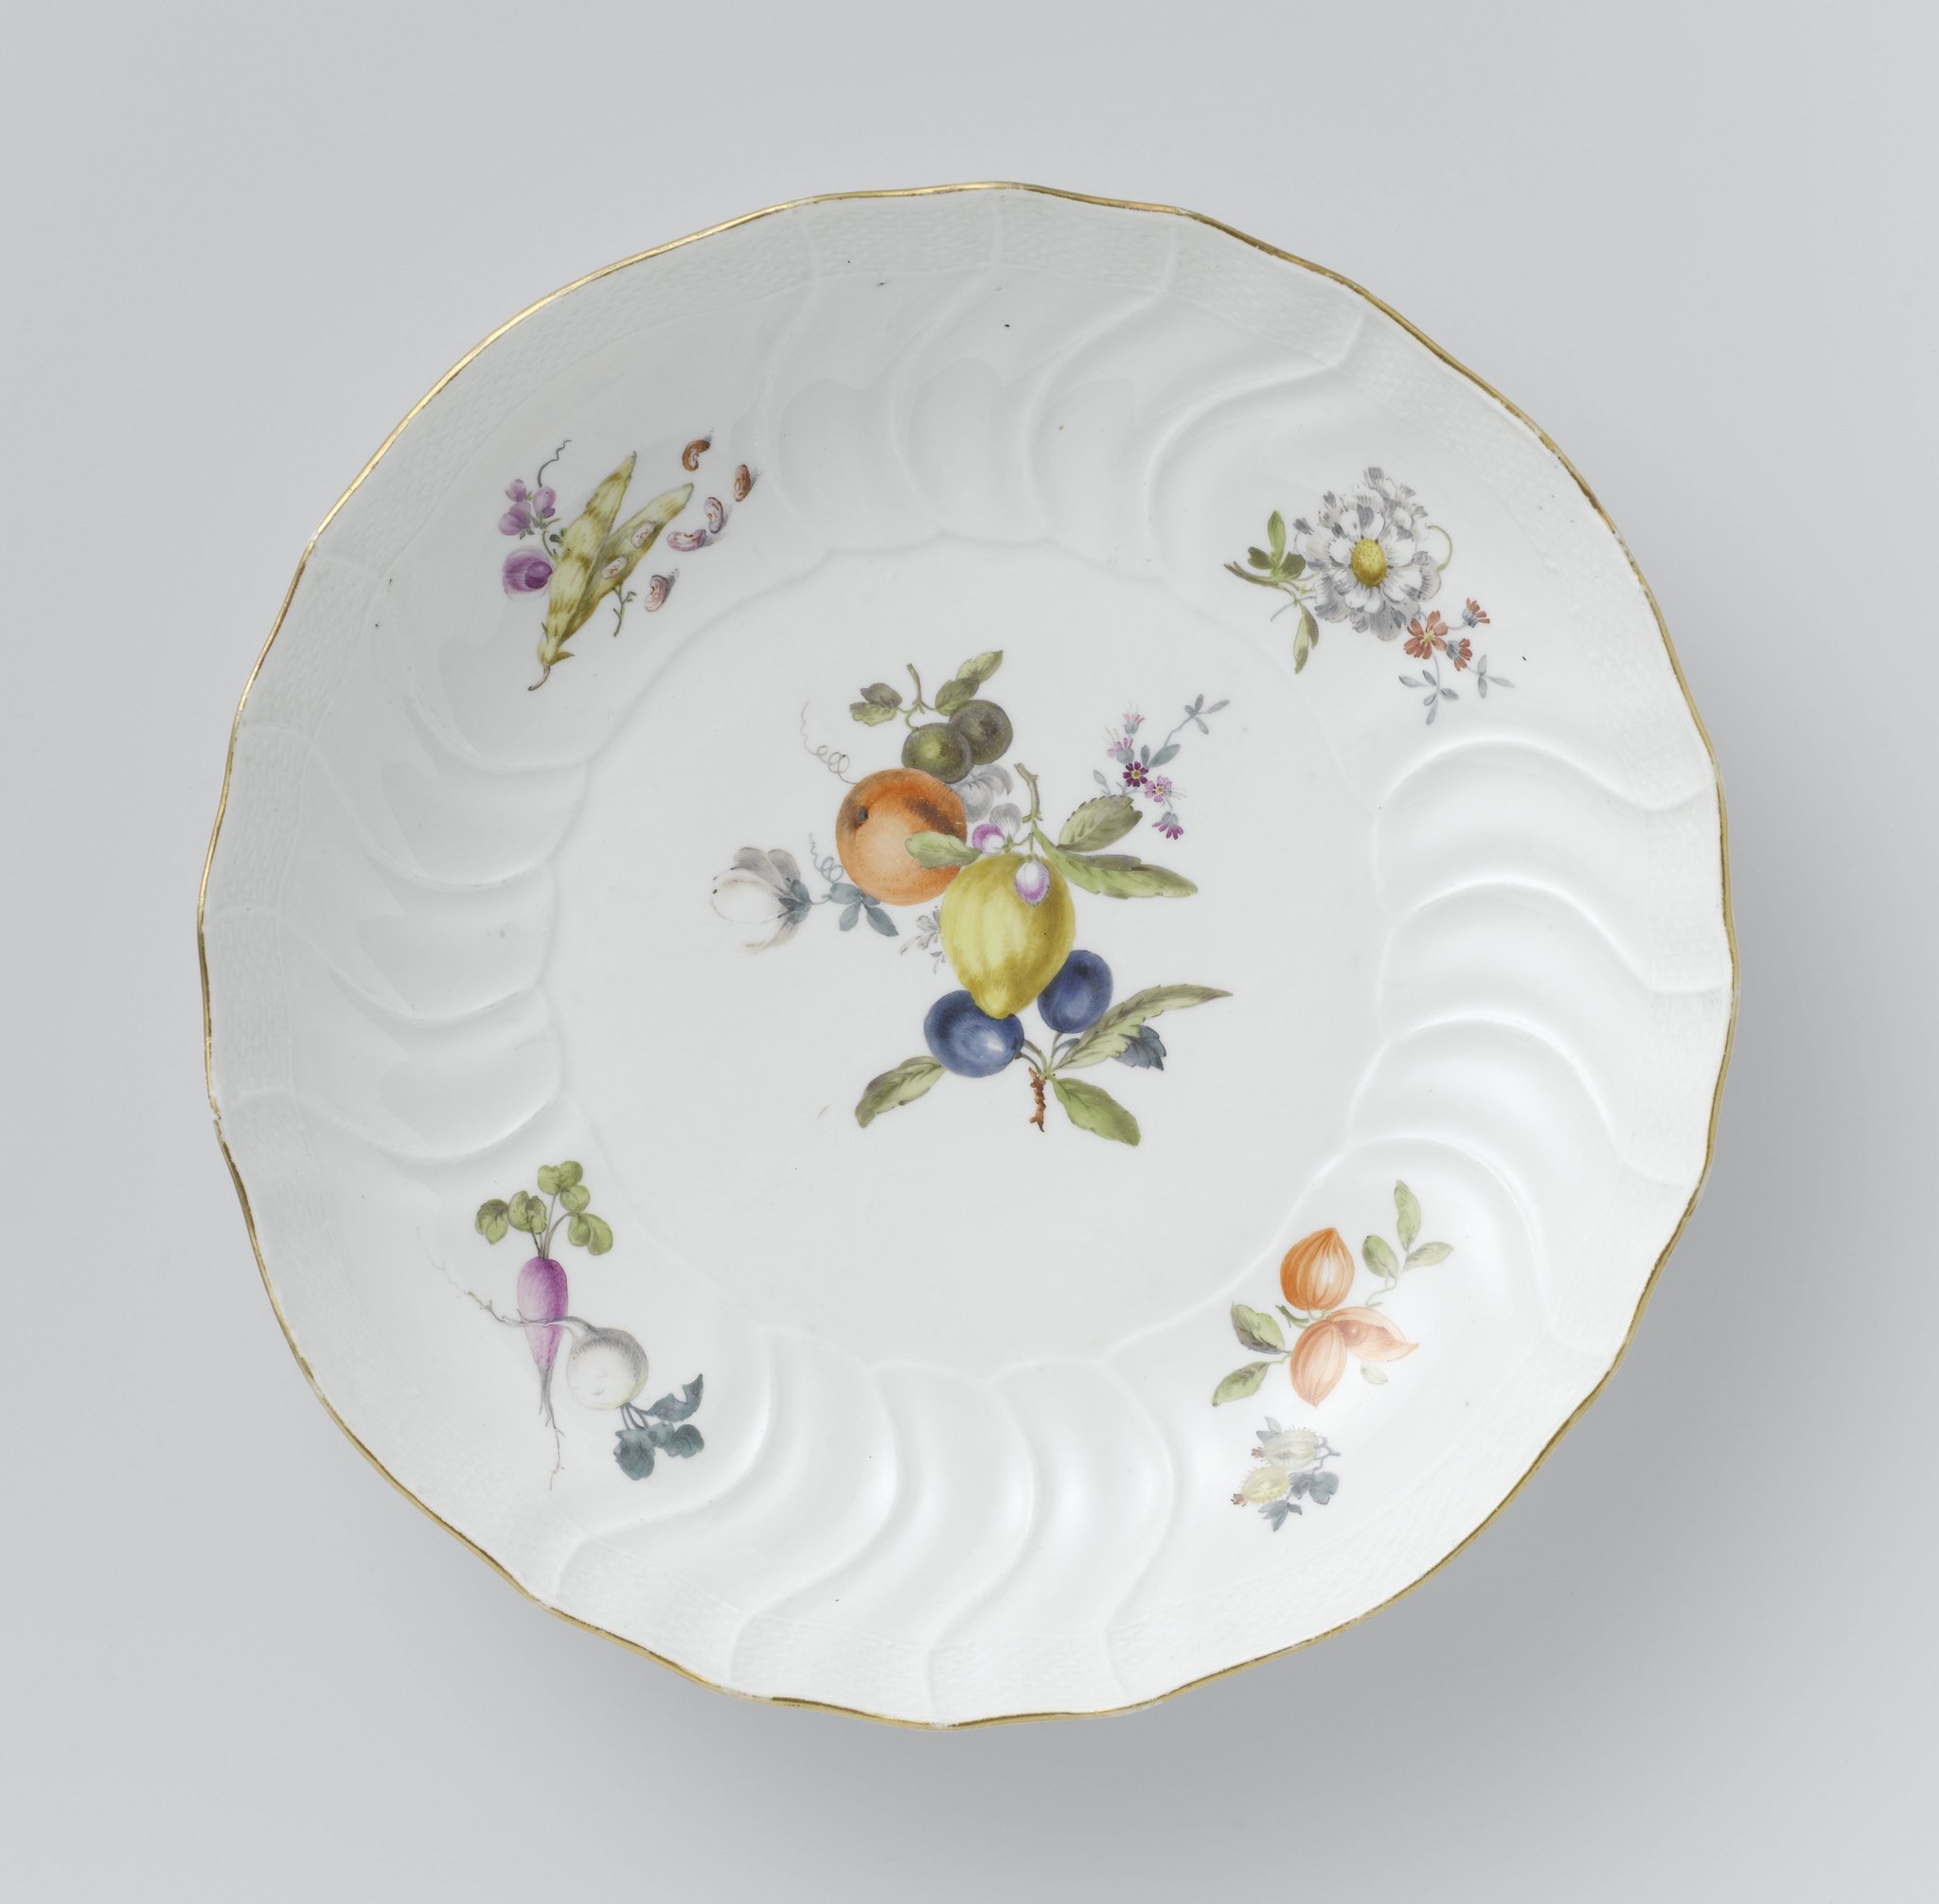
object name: eating drinking utensil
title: Schotel, veelkleurig beschilderd met Deutsche Blumen, insekten en vruchten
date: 1750-1760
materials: porcelain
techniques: painted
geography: meissen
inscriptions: factory mark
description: Ronde schotel van beschilderd porselein. De schotel is beschilderd met Deutsche Blumen, insekten en vruchten. De rand is in reliëf versierd met het Neuozier-patroon. De schotel is gemerkt en hoort bij een servies (BK-17474-1 t/m BK-17474-253).